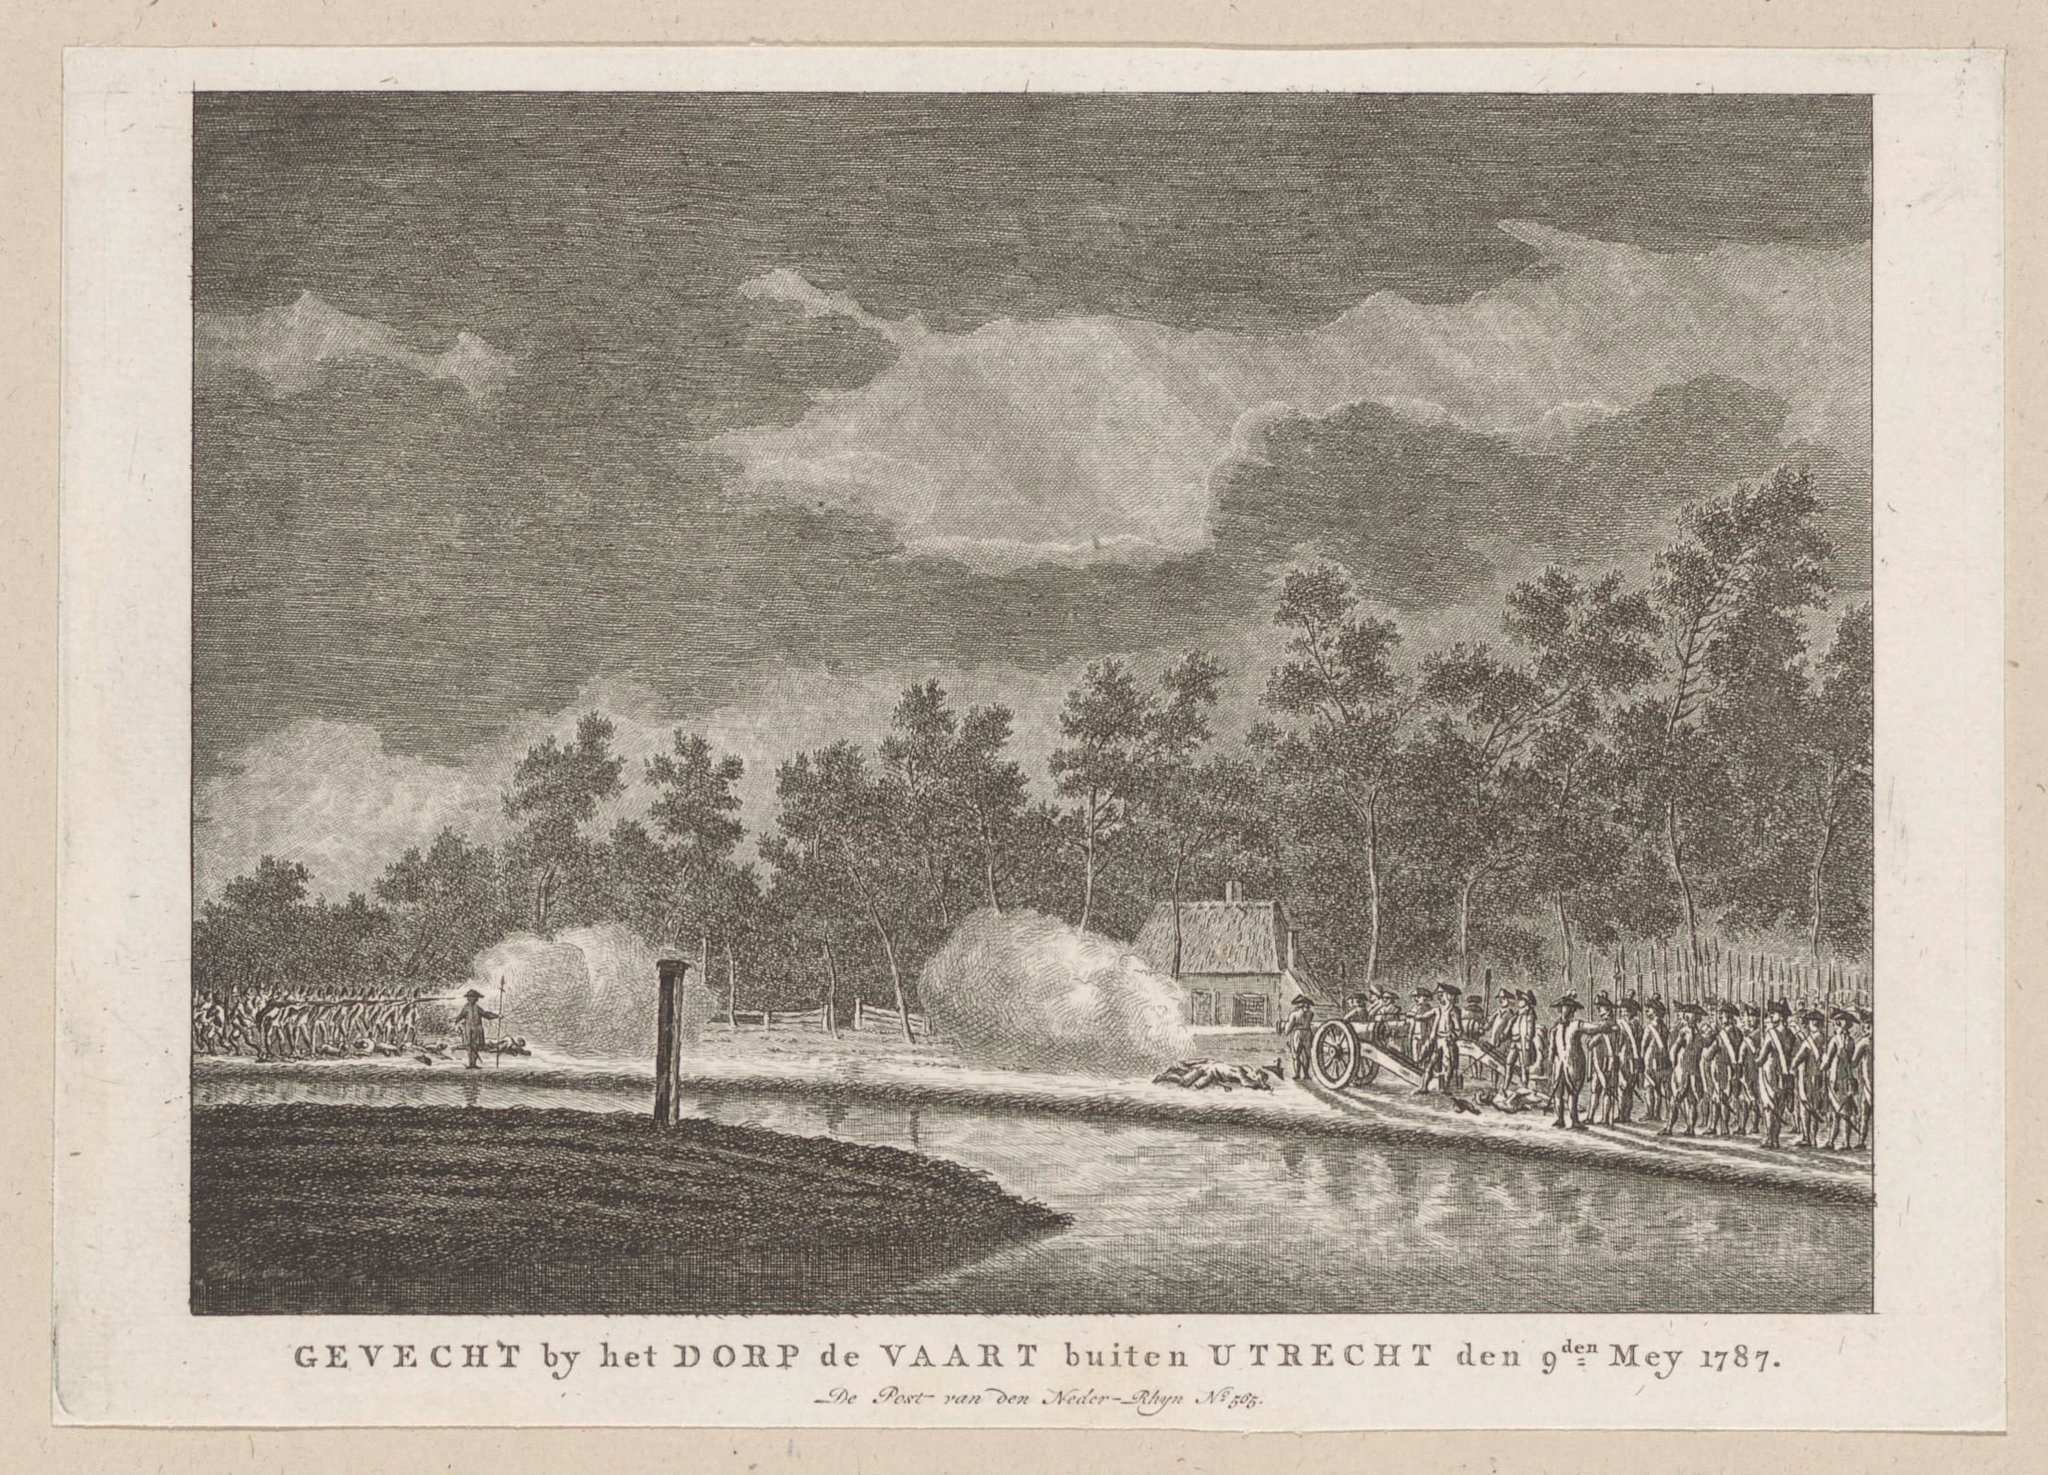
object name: print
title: Gevecht by het dorp de Vaart buiten Utrecht den 9den Mey 1787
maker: Anonymous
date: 1787-1792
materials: paper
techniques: engraving, etching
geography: northern netherlands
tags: battle (+ citizen soldiery, civil guard, citizen militia)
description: Oorspronkelijk gebruikt als illustratie in: Hoen, Pieter ’t ed. De Post van den Neder-Rhyn, no. 565. Hier gebruikt als illustratie in: Rogge, Cornelis. Beknopte historie der onlusten in de Nederlanden. Sedert de onderhandelingen over de gewapende neutraliteit in 1780. 4 delen. Braband 1790-1792.